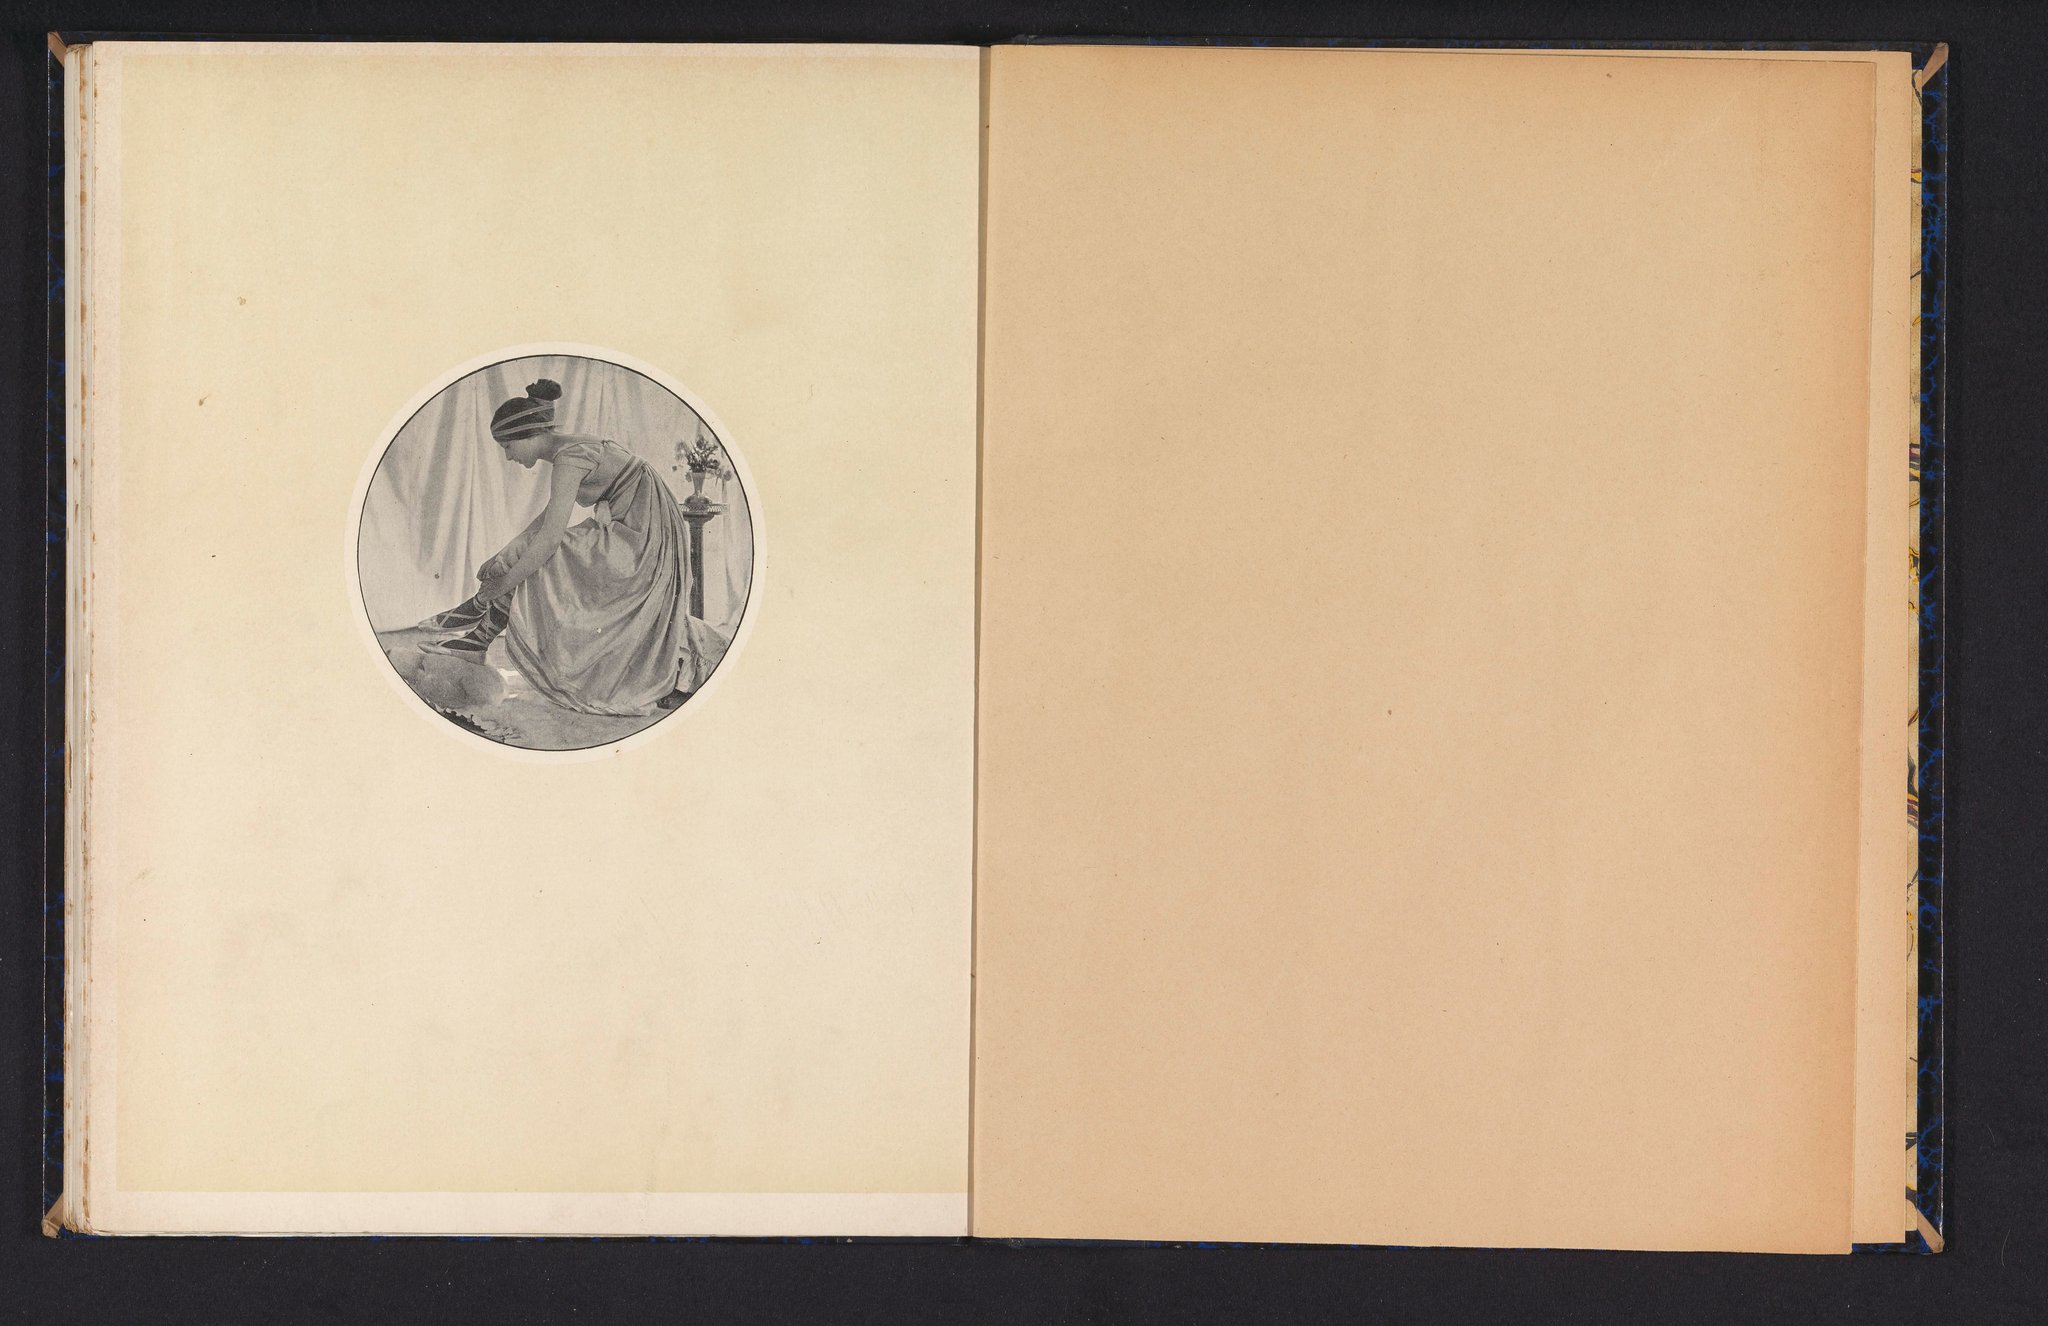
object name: page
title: Vrouw strikt de veters van haar schoenen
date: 1886-1896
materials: paper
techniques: autotype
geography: france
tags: putting on (tying) or taking off (untying) sandals or shoes - aa - female human figure